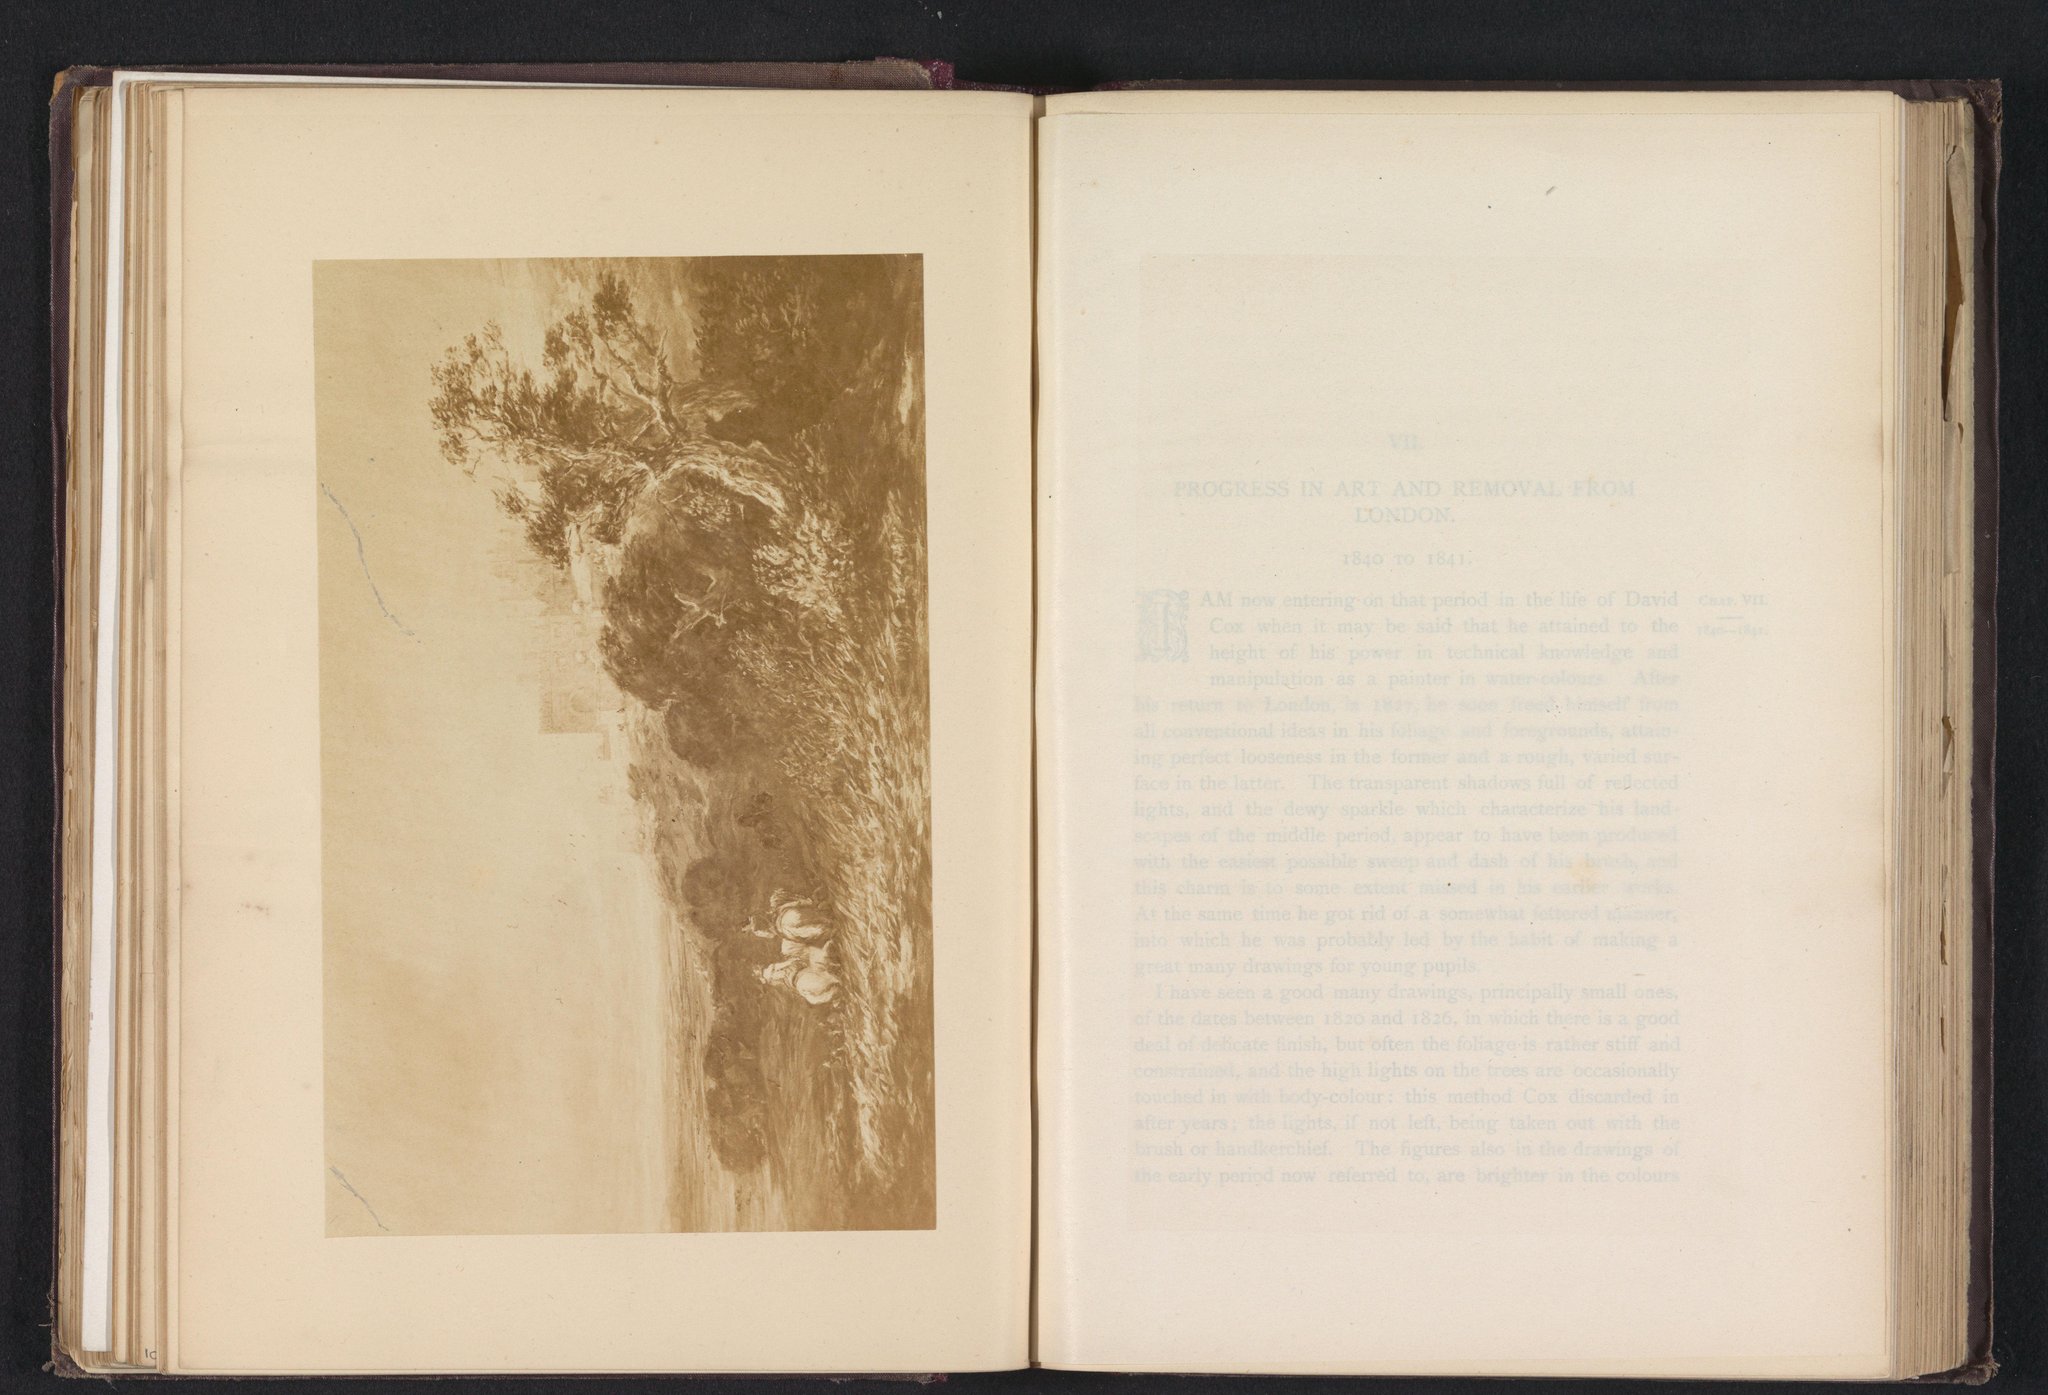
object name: photograph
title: Fotoreproductie van een tekening van Bolsover Castle met ruiters door David Cox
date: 1863-1873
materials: photographic support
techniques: albumen print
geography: derbyshire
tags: riding a horse, ass, or mule; rider, horseman, drawing, sketch, castle